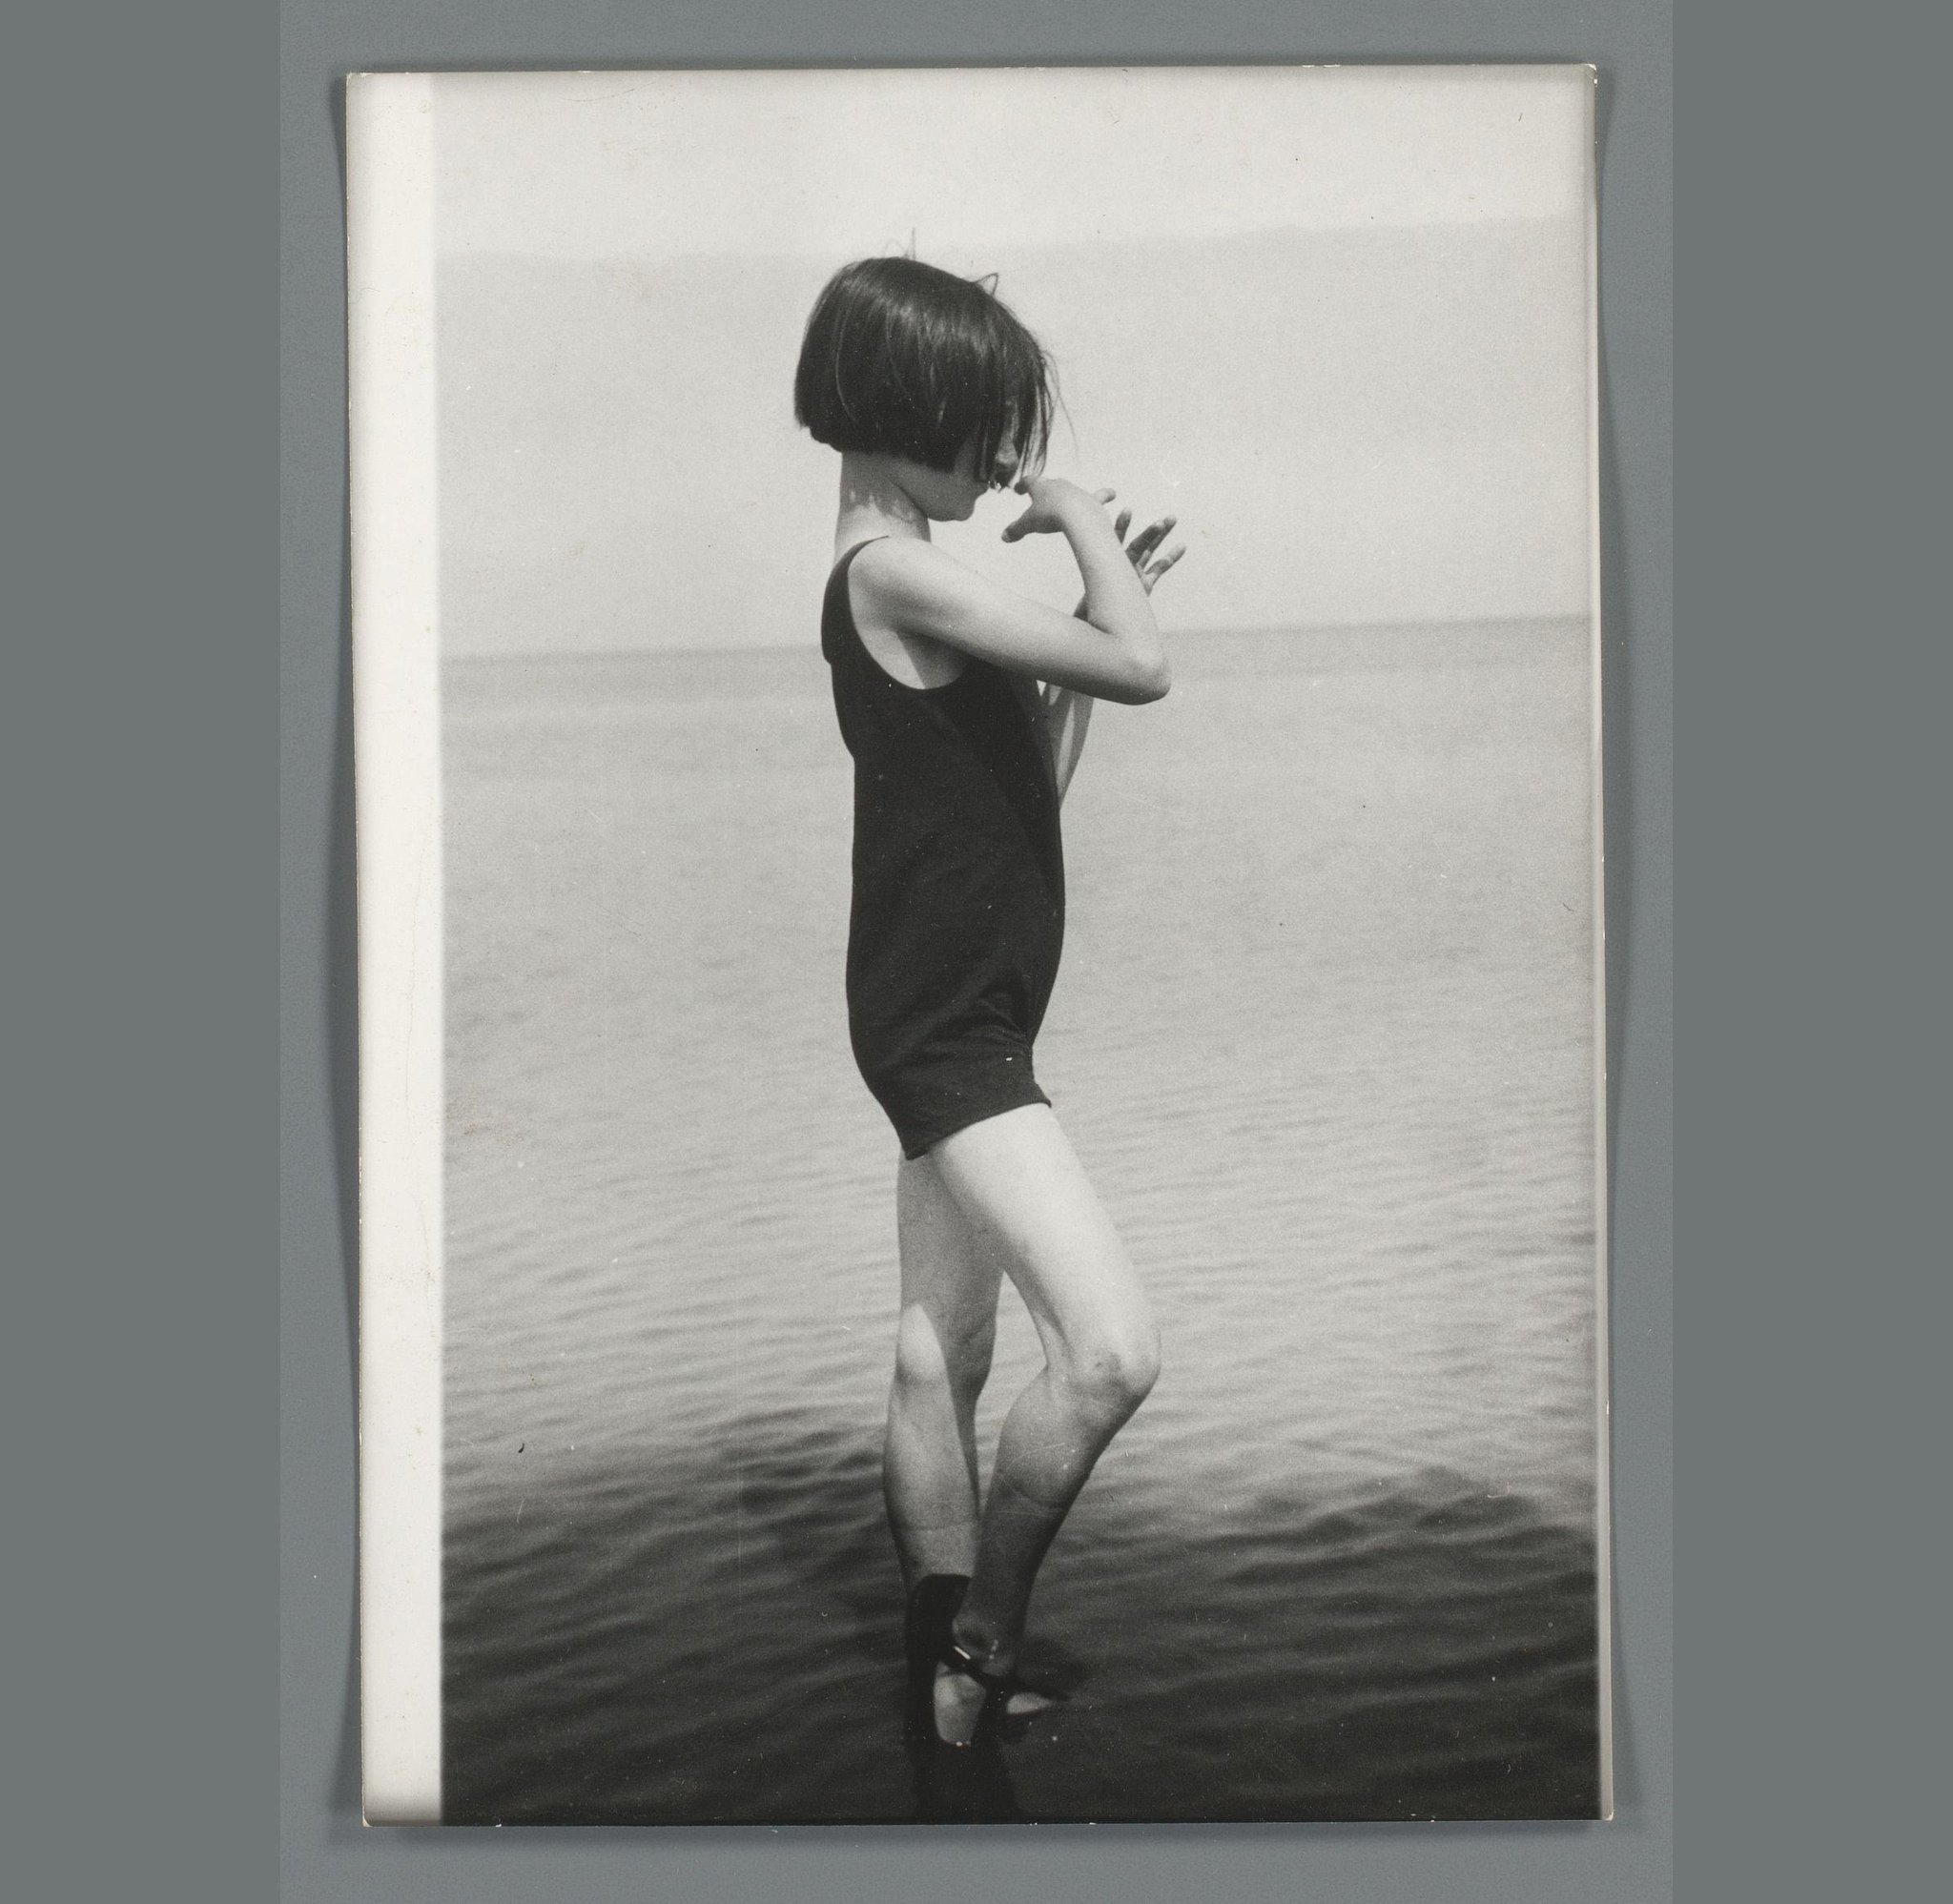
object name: photograph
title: Meisje staand in zee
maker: Anonymous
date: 1920-1950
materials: paper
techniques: gelatin silver print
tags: historical persons not known by name - bb - woman, girl (child between toddler and youth), in or beside the water (on the beach)